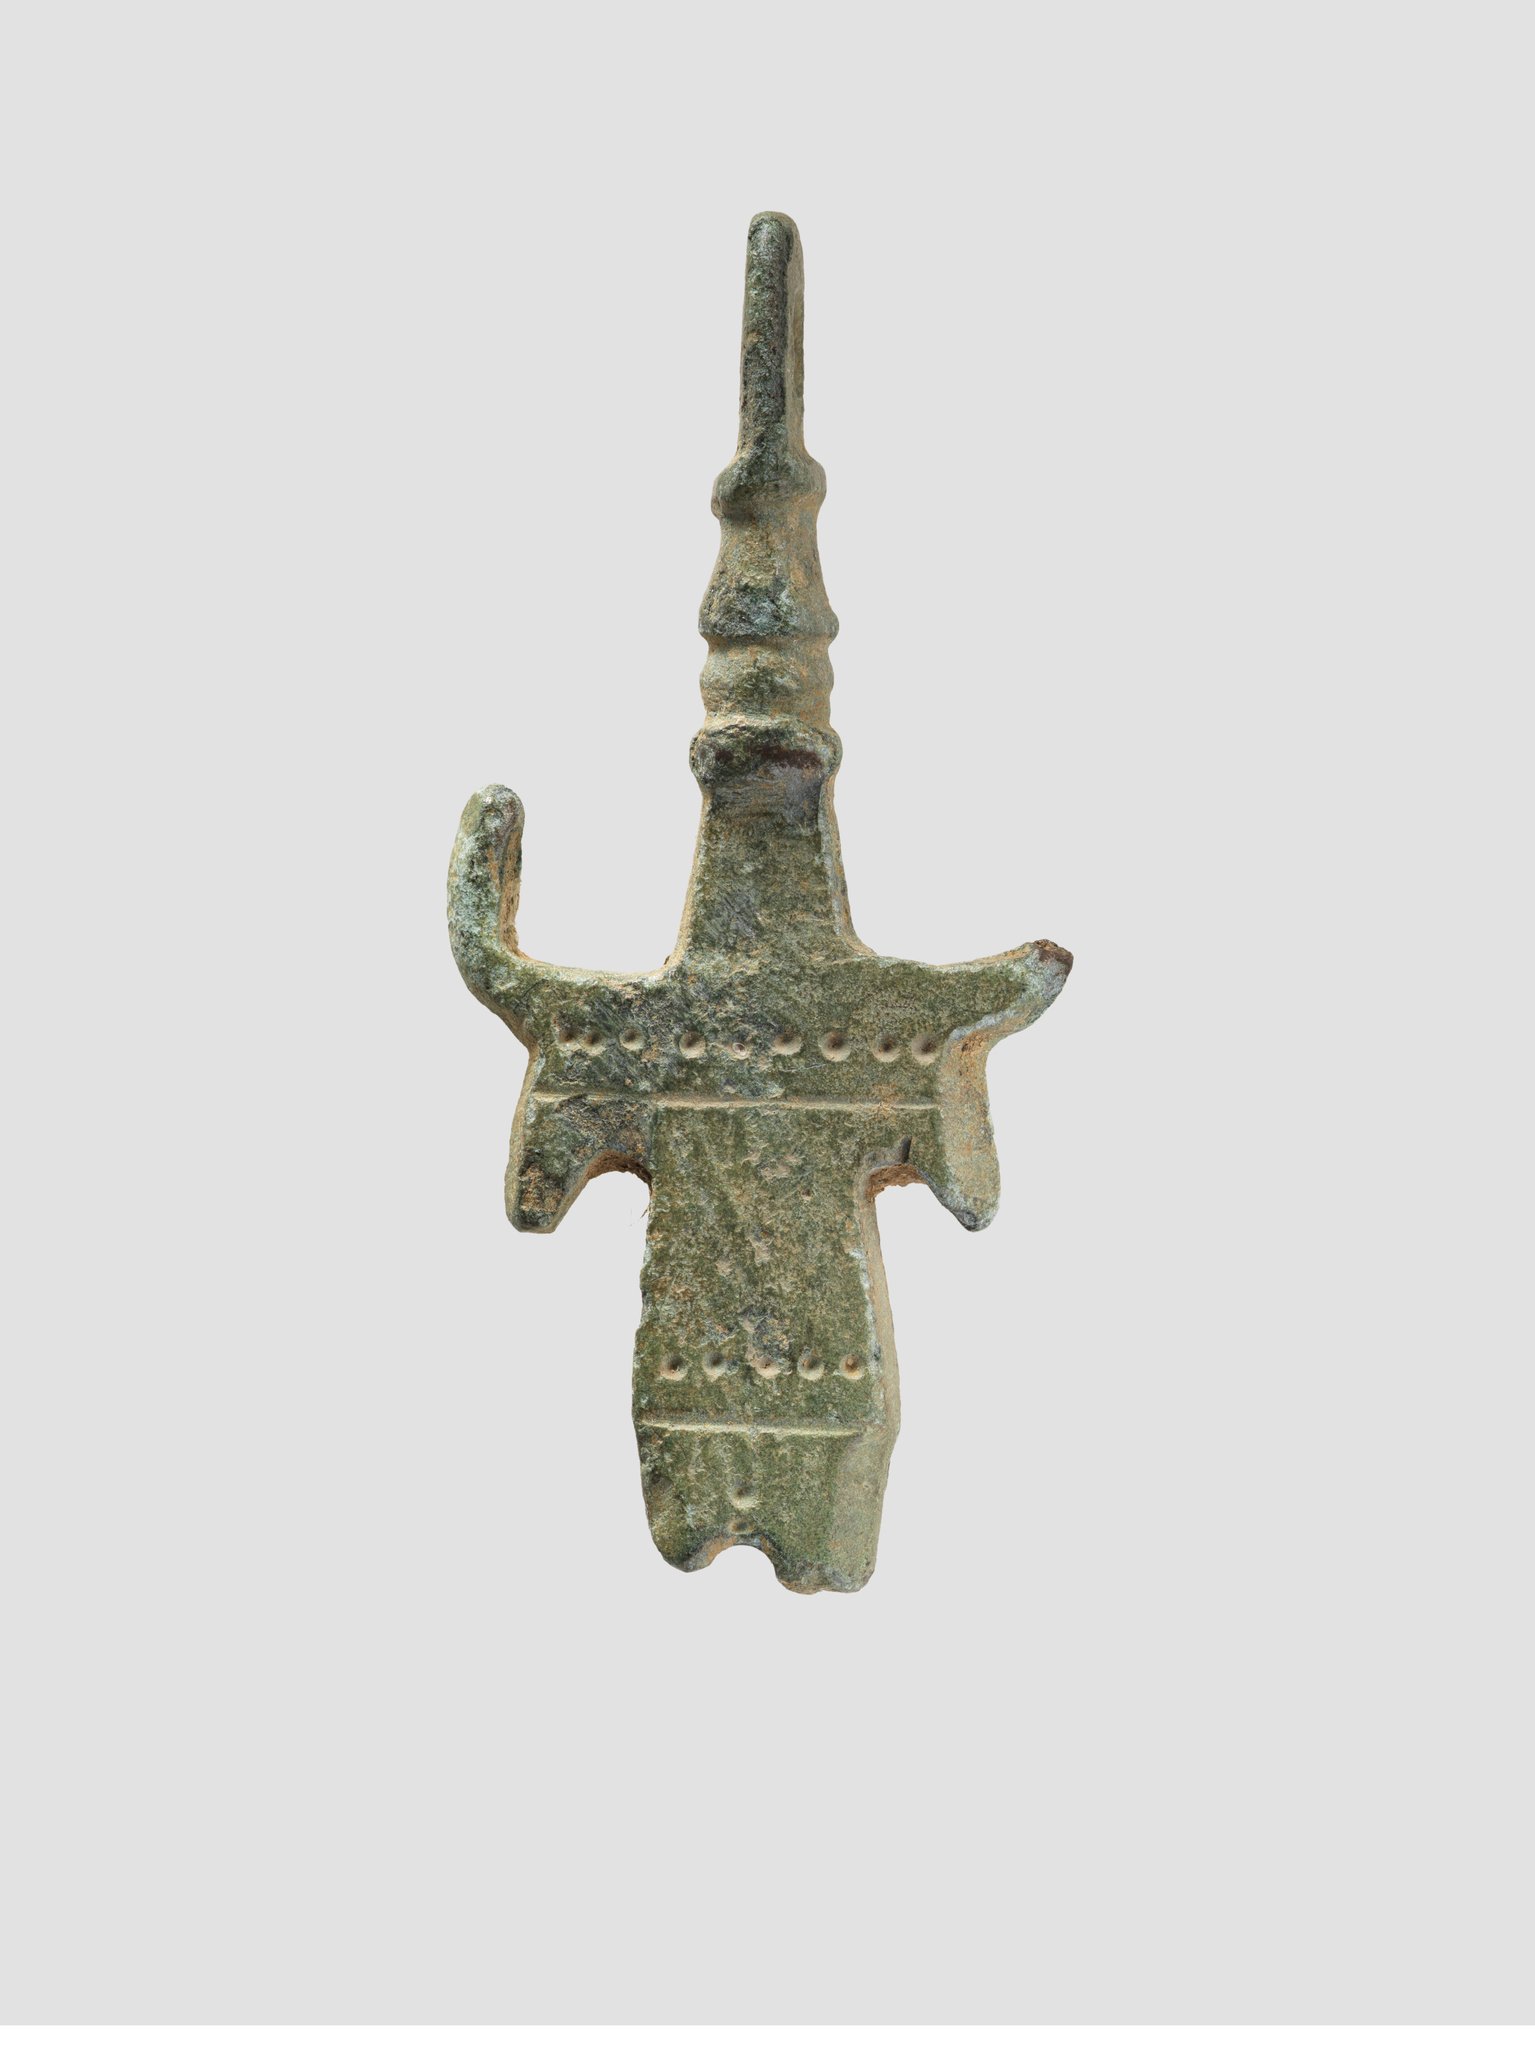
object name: ornament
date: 1-1000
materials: bronze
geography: anatolia (?)